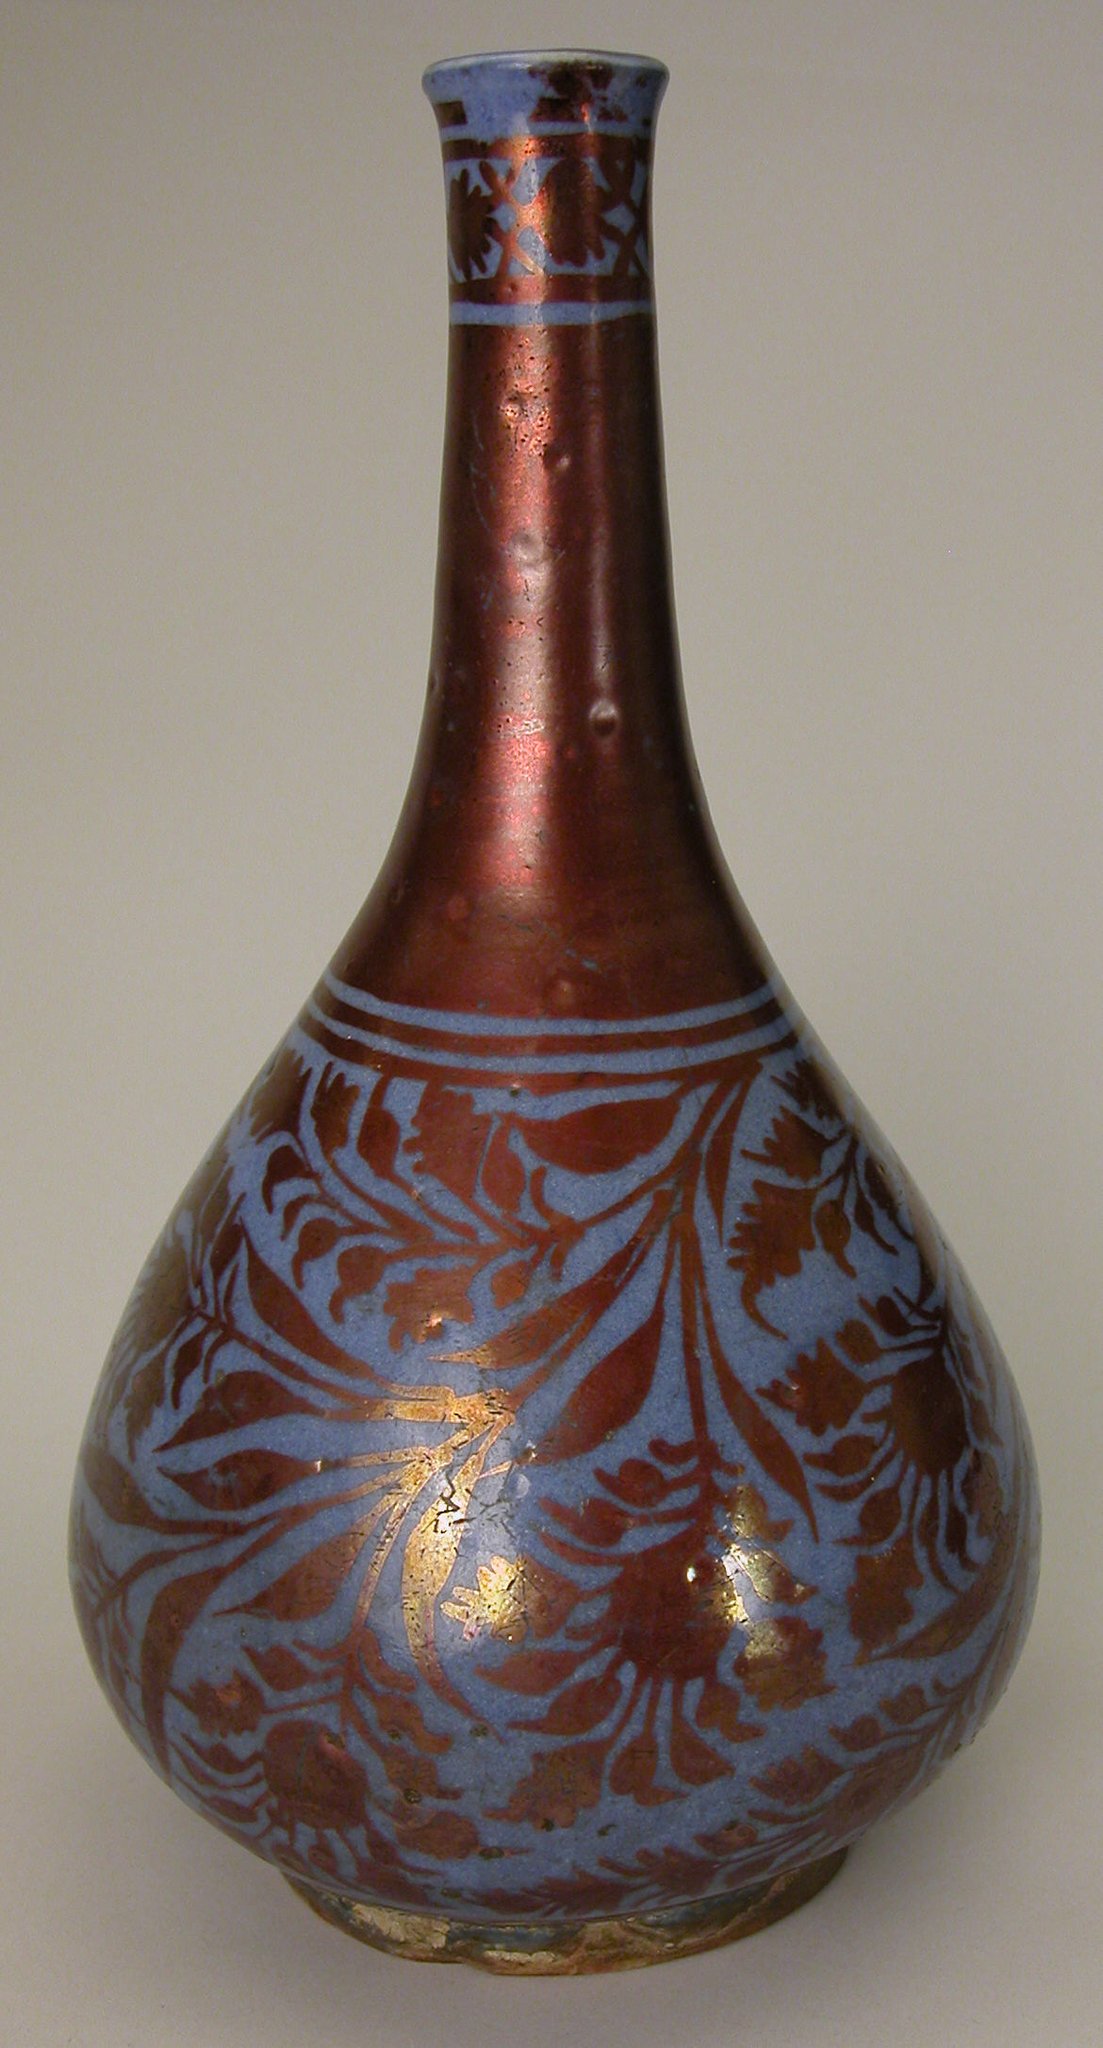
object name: bottle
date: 1587-1628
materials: glaze, stonepaste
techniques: luster painting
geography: iran